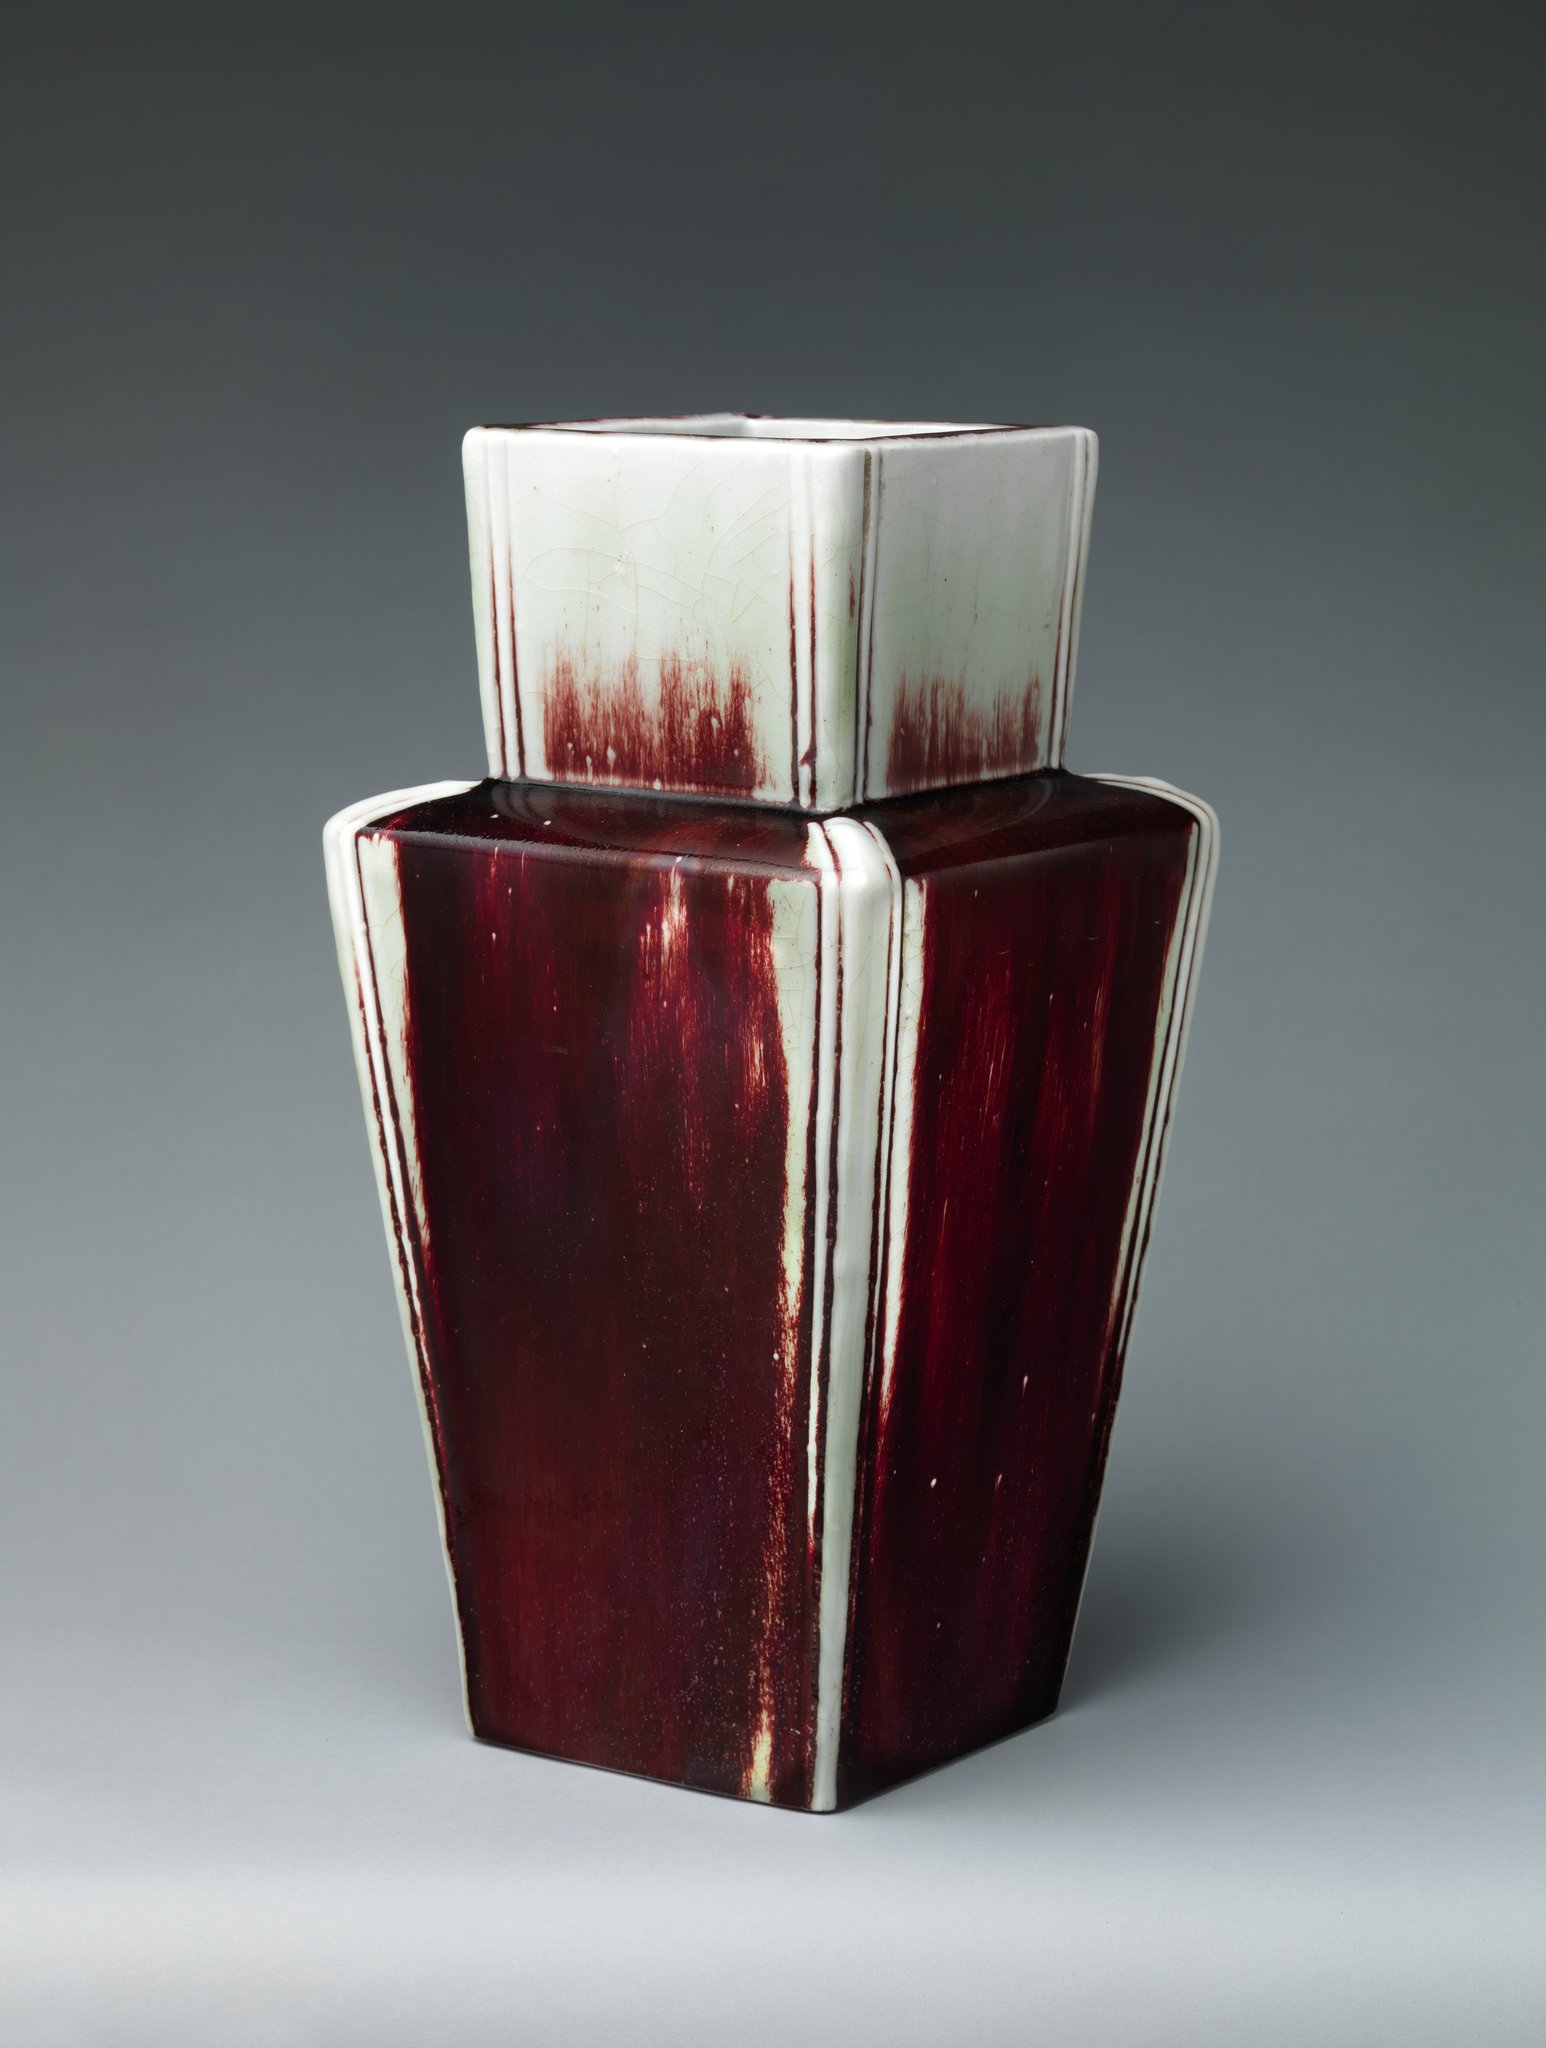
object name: vase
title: Square vase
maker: ernest chaplet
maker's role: maker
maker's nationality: french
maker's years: 1835-1909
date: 1889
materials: hard paste porcelain